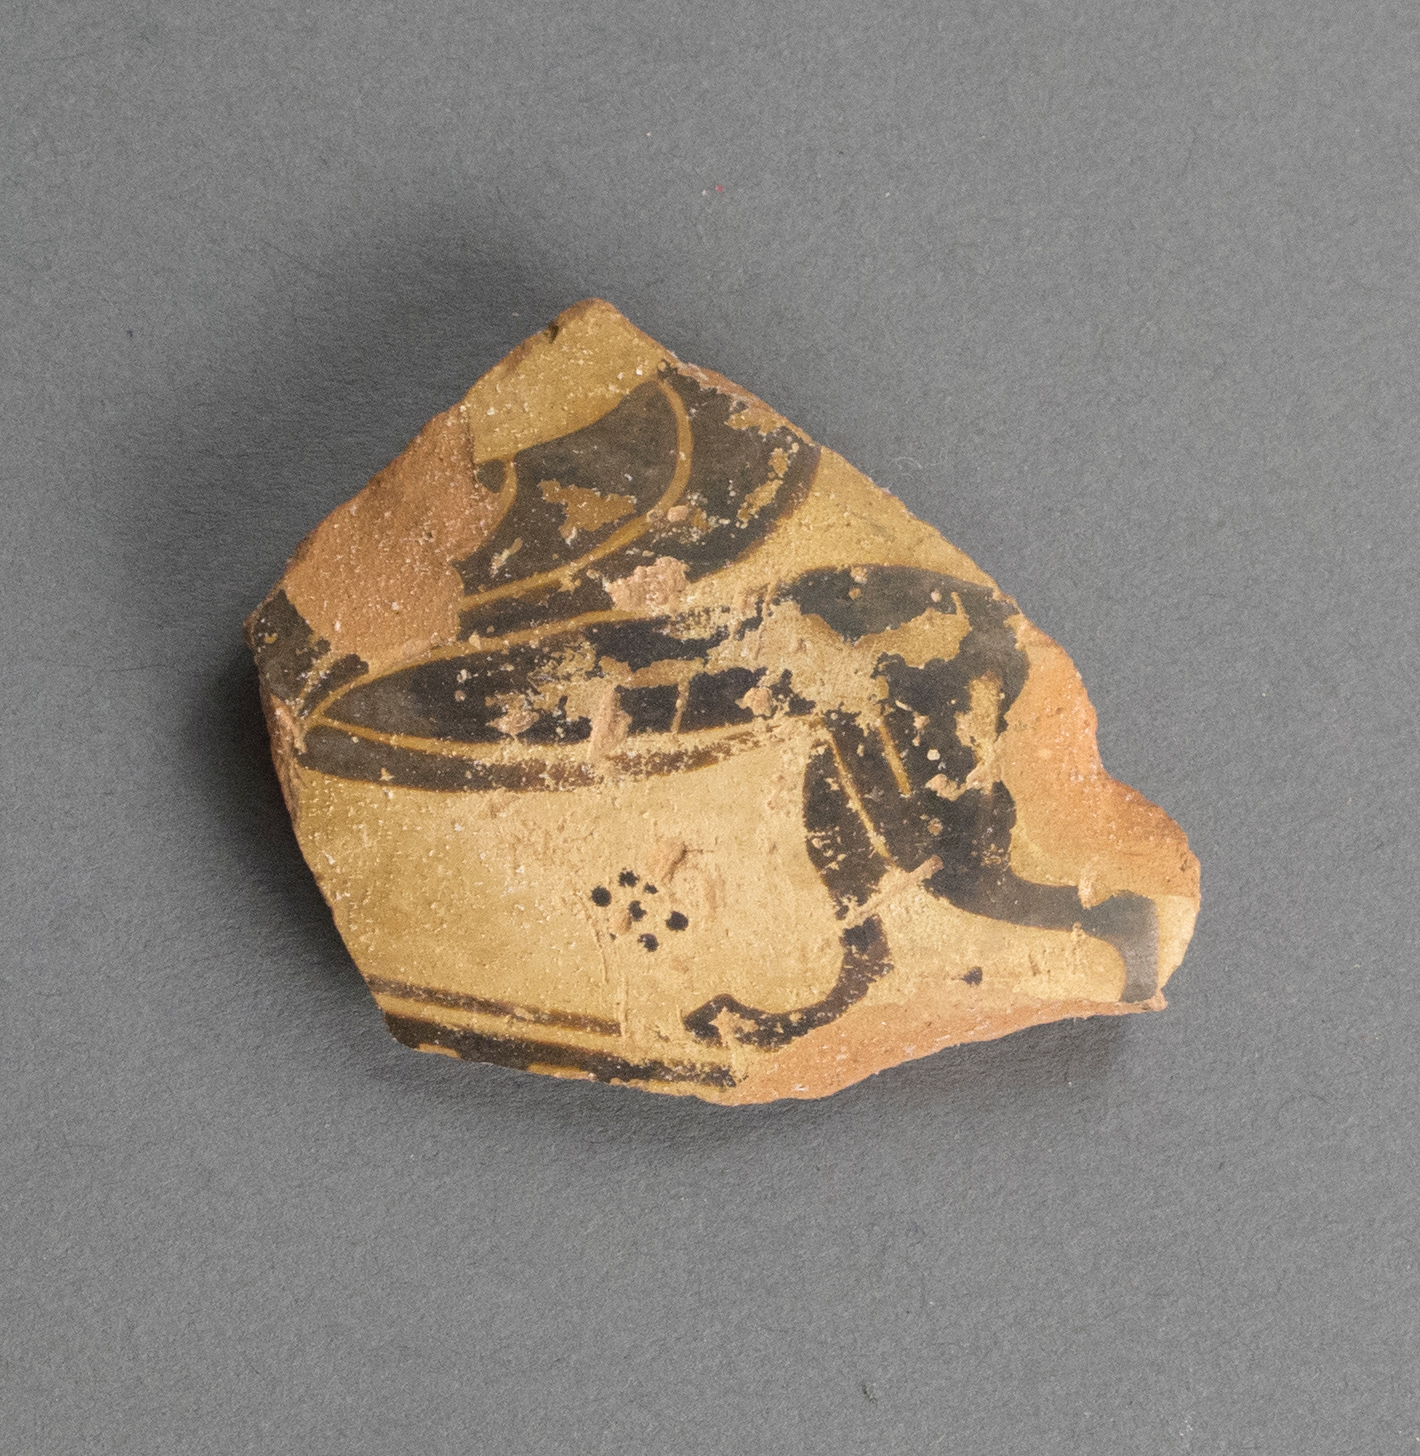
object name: vase fragment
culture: east greek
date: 560-550 BCE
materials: terracotta